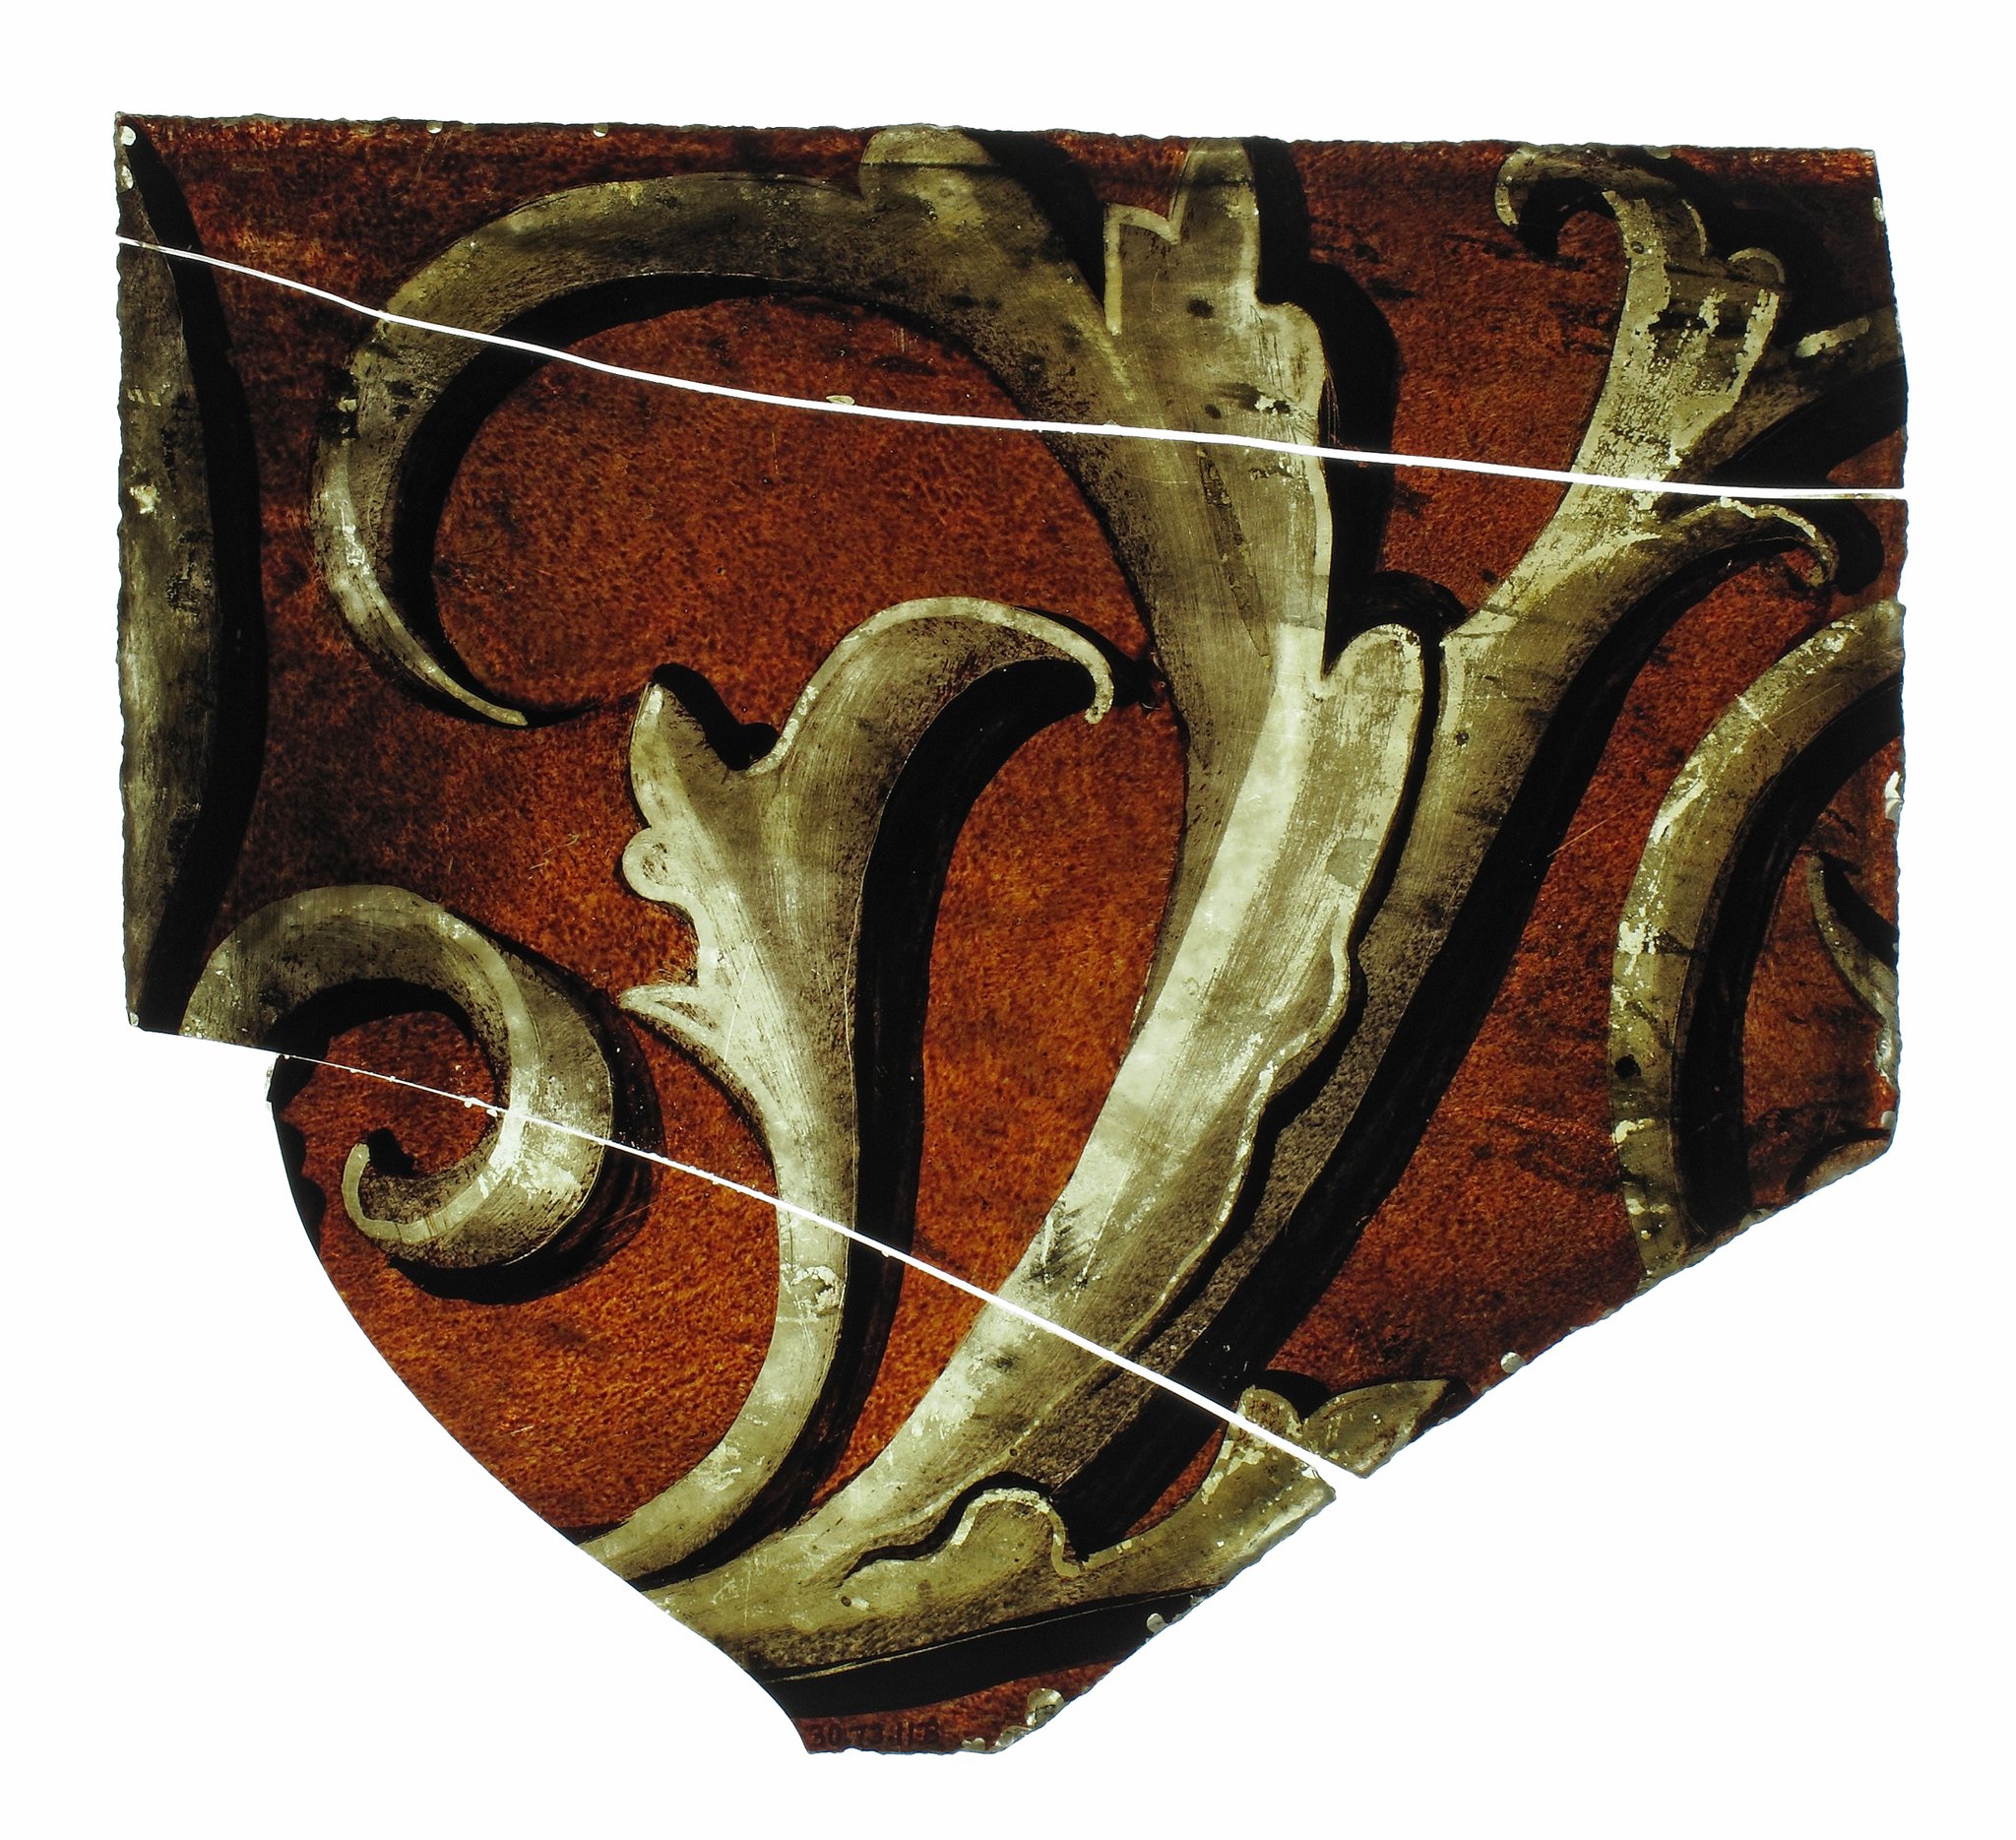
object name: fragment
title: Glass Fragment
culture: european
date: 1601-1900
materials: glass